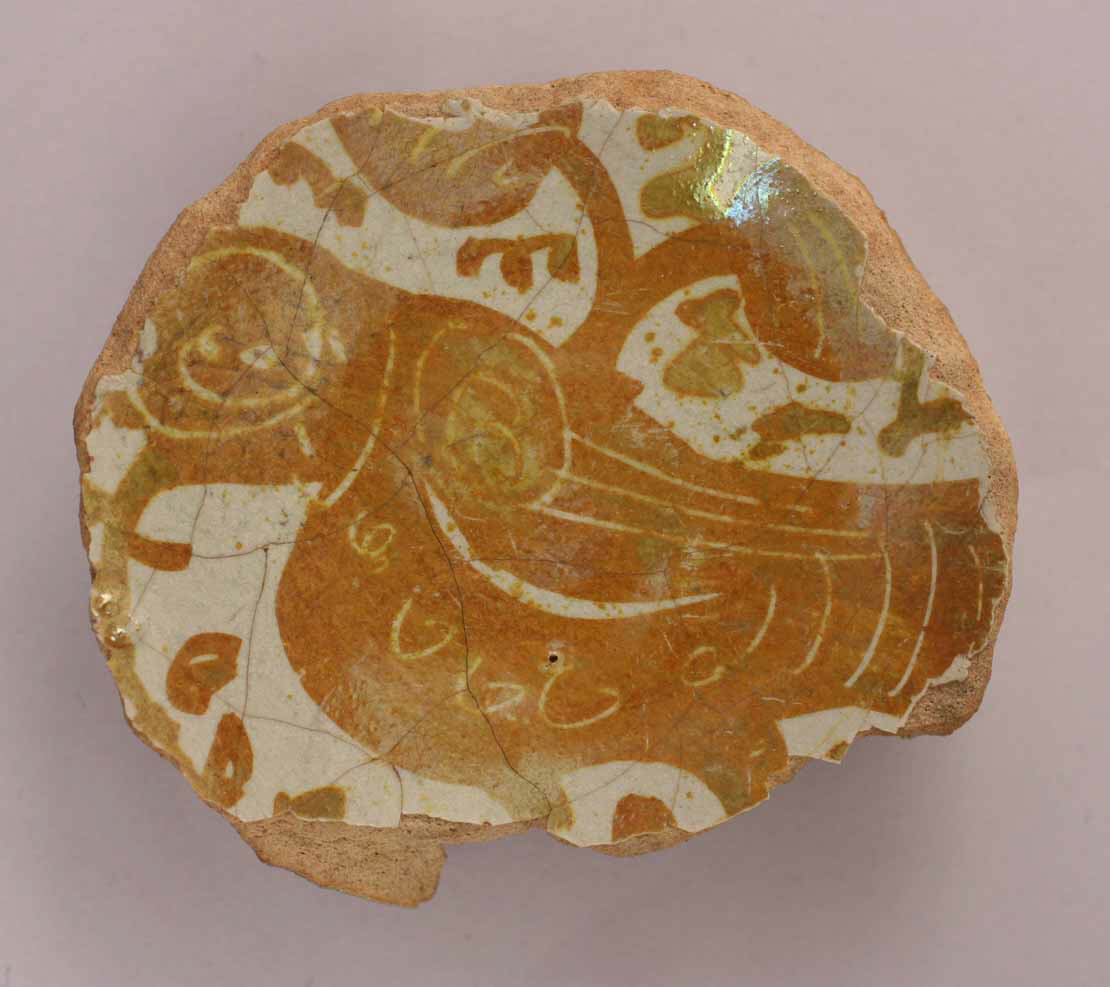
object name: ceramic fragment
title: Fragment of a Bowl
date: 1001-1200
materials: earthenware, glaze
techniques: luster painting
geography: egypt